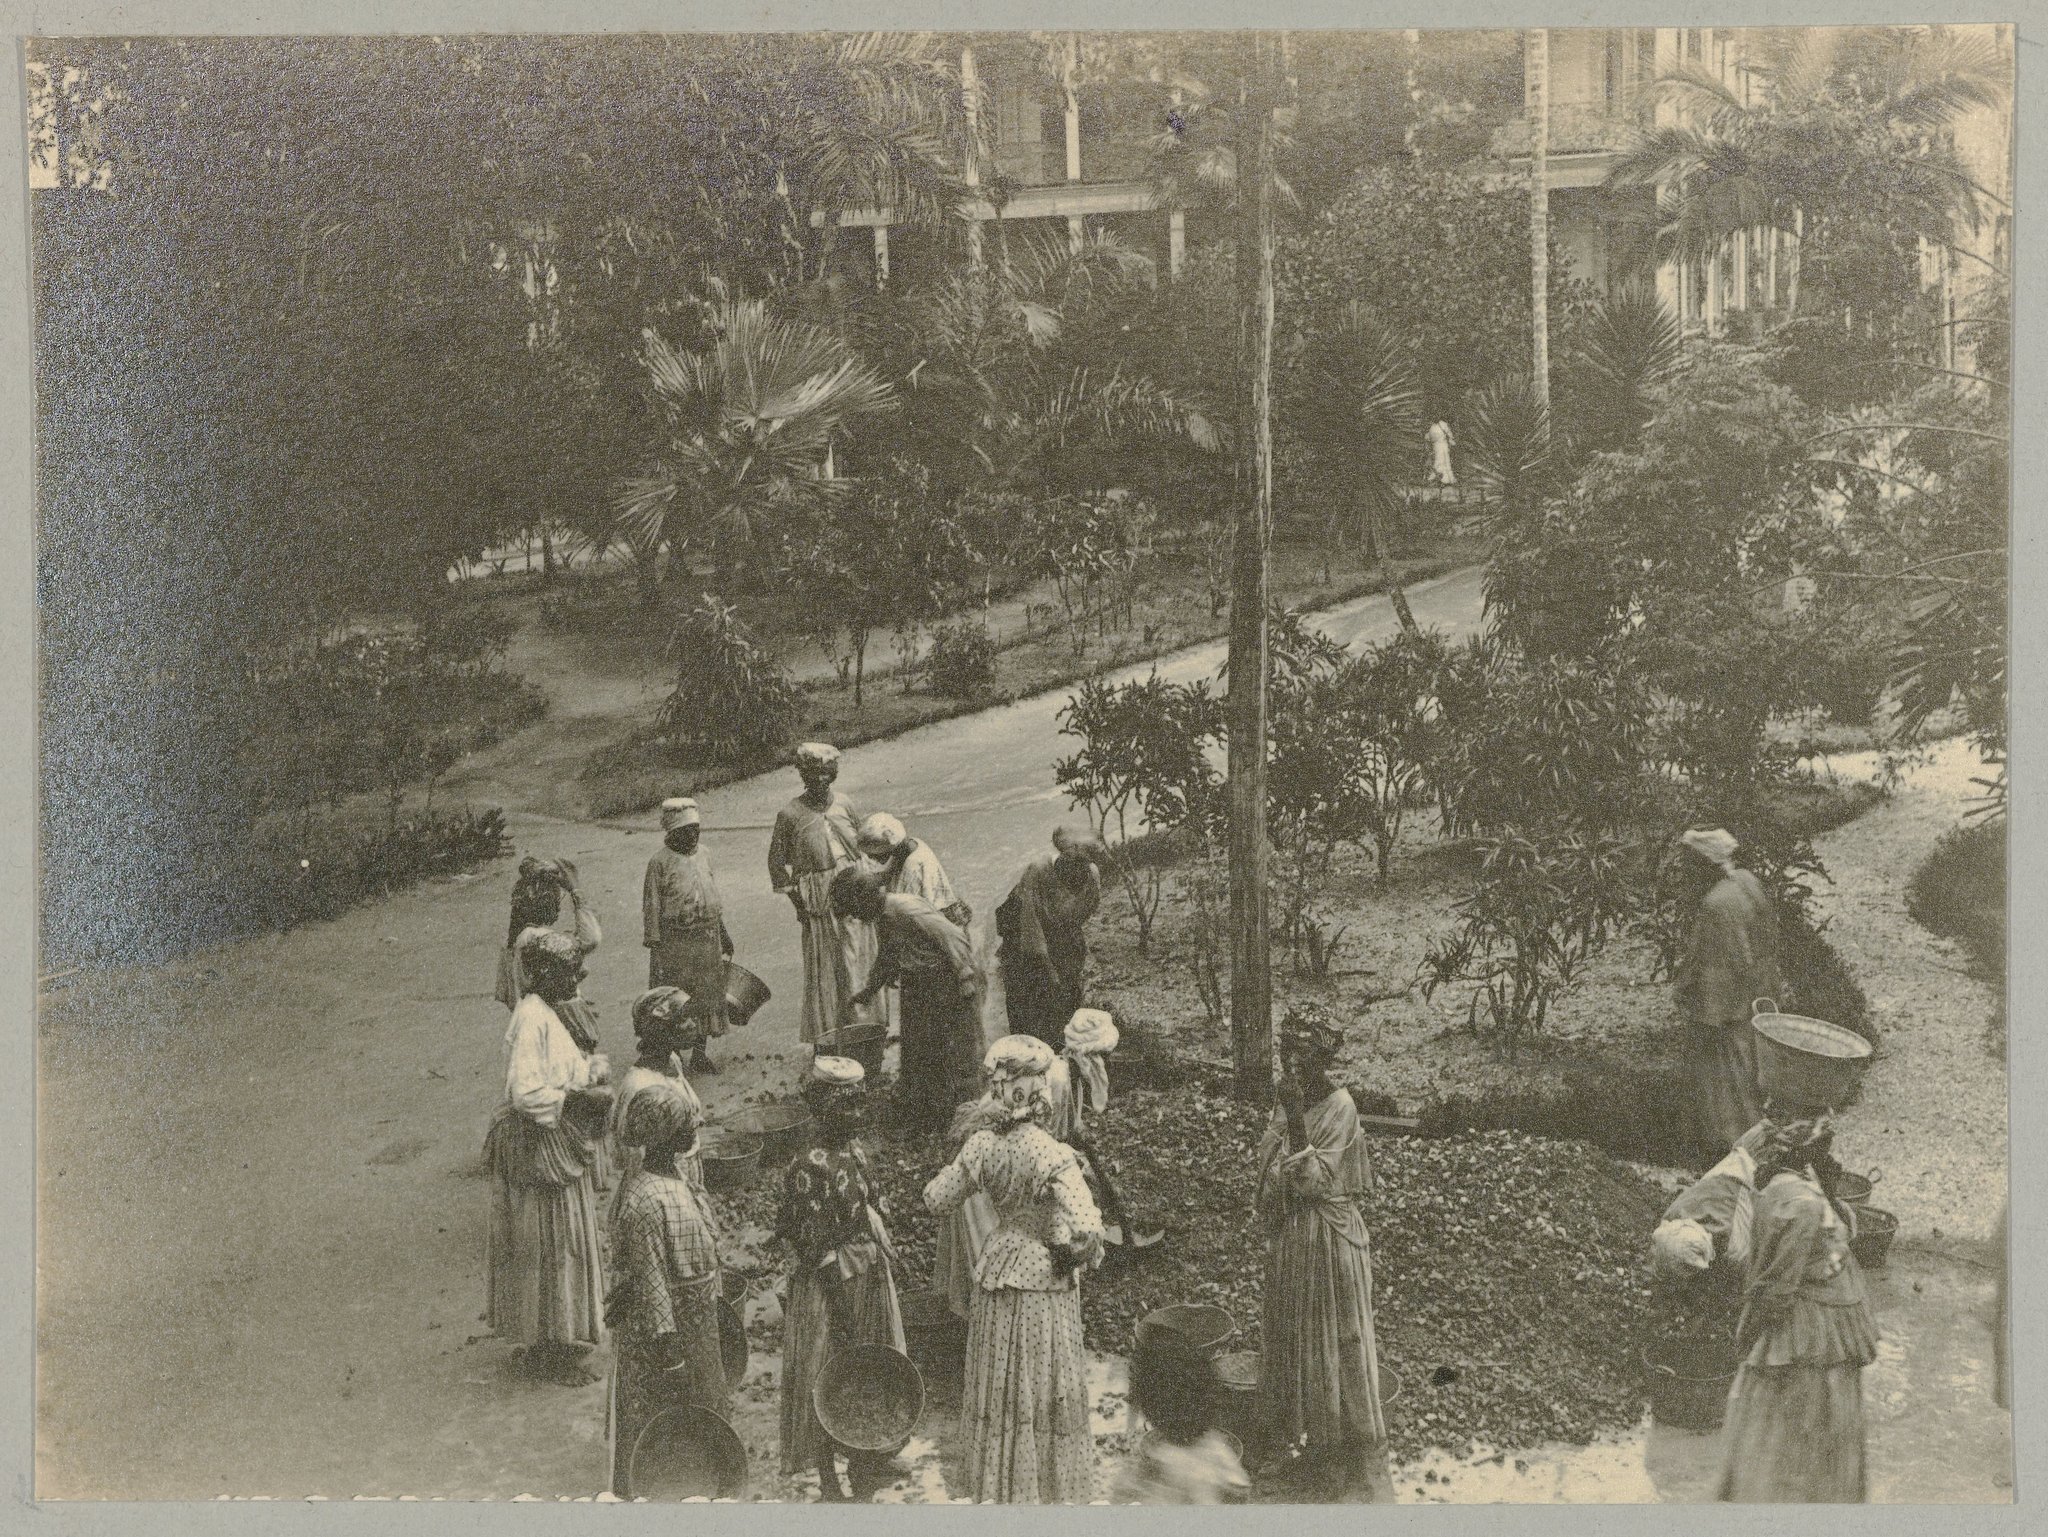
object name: photograph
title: In den tuin van het hospitaal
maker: hendrik doijer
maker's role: engineer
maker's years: 1863-1925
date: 1903-1910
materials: photographic support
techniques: gelatin silver print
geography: suriname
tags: suriname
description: Een groep Surinaamse vrouwen staande bij elkaar in de tuin van het hospitaal, waarschijnlijk te Paramaribo. Onderdeel van het fotoalbum Souvenir de Voyage (deel 5), over het leven van de familie Doijer in en rond de plantage Ma Retraite in Suriname in de jaren 1903-1910.